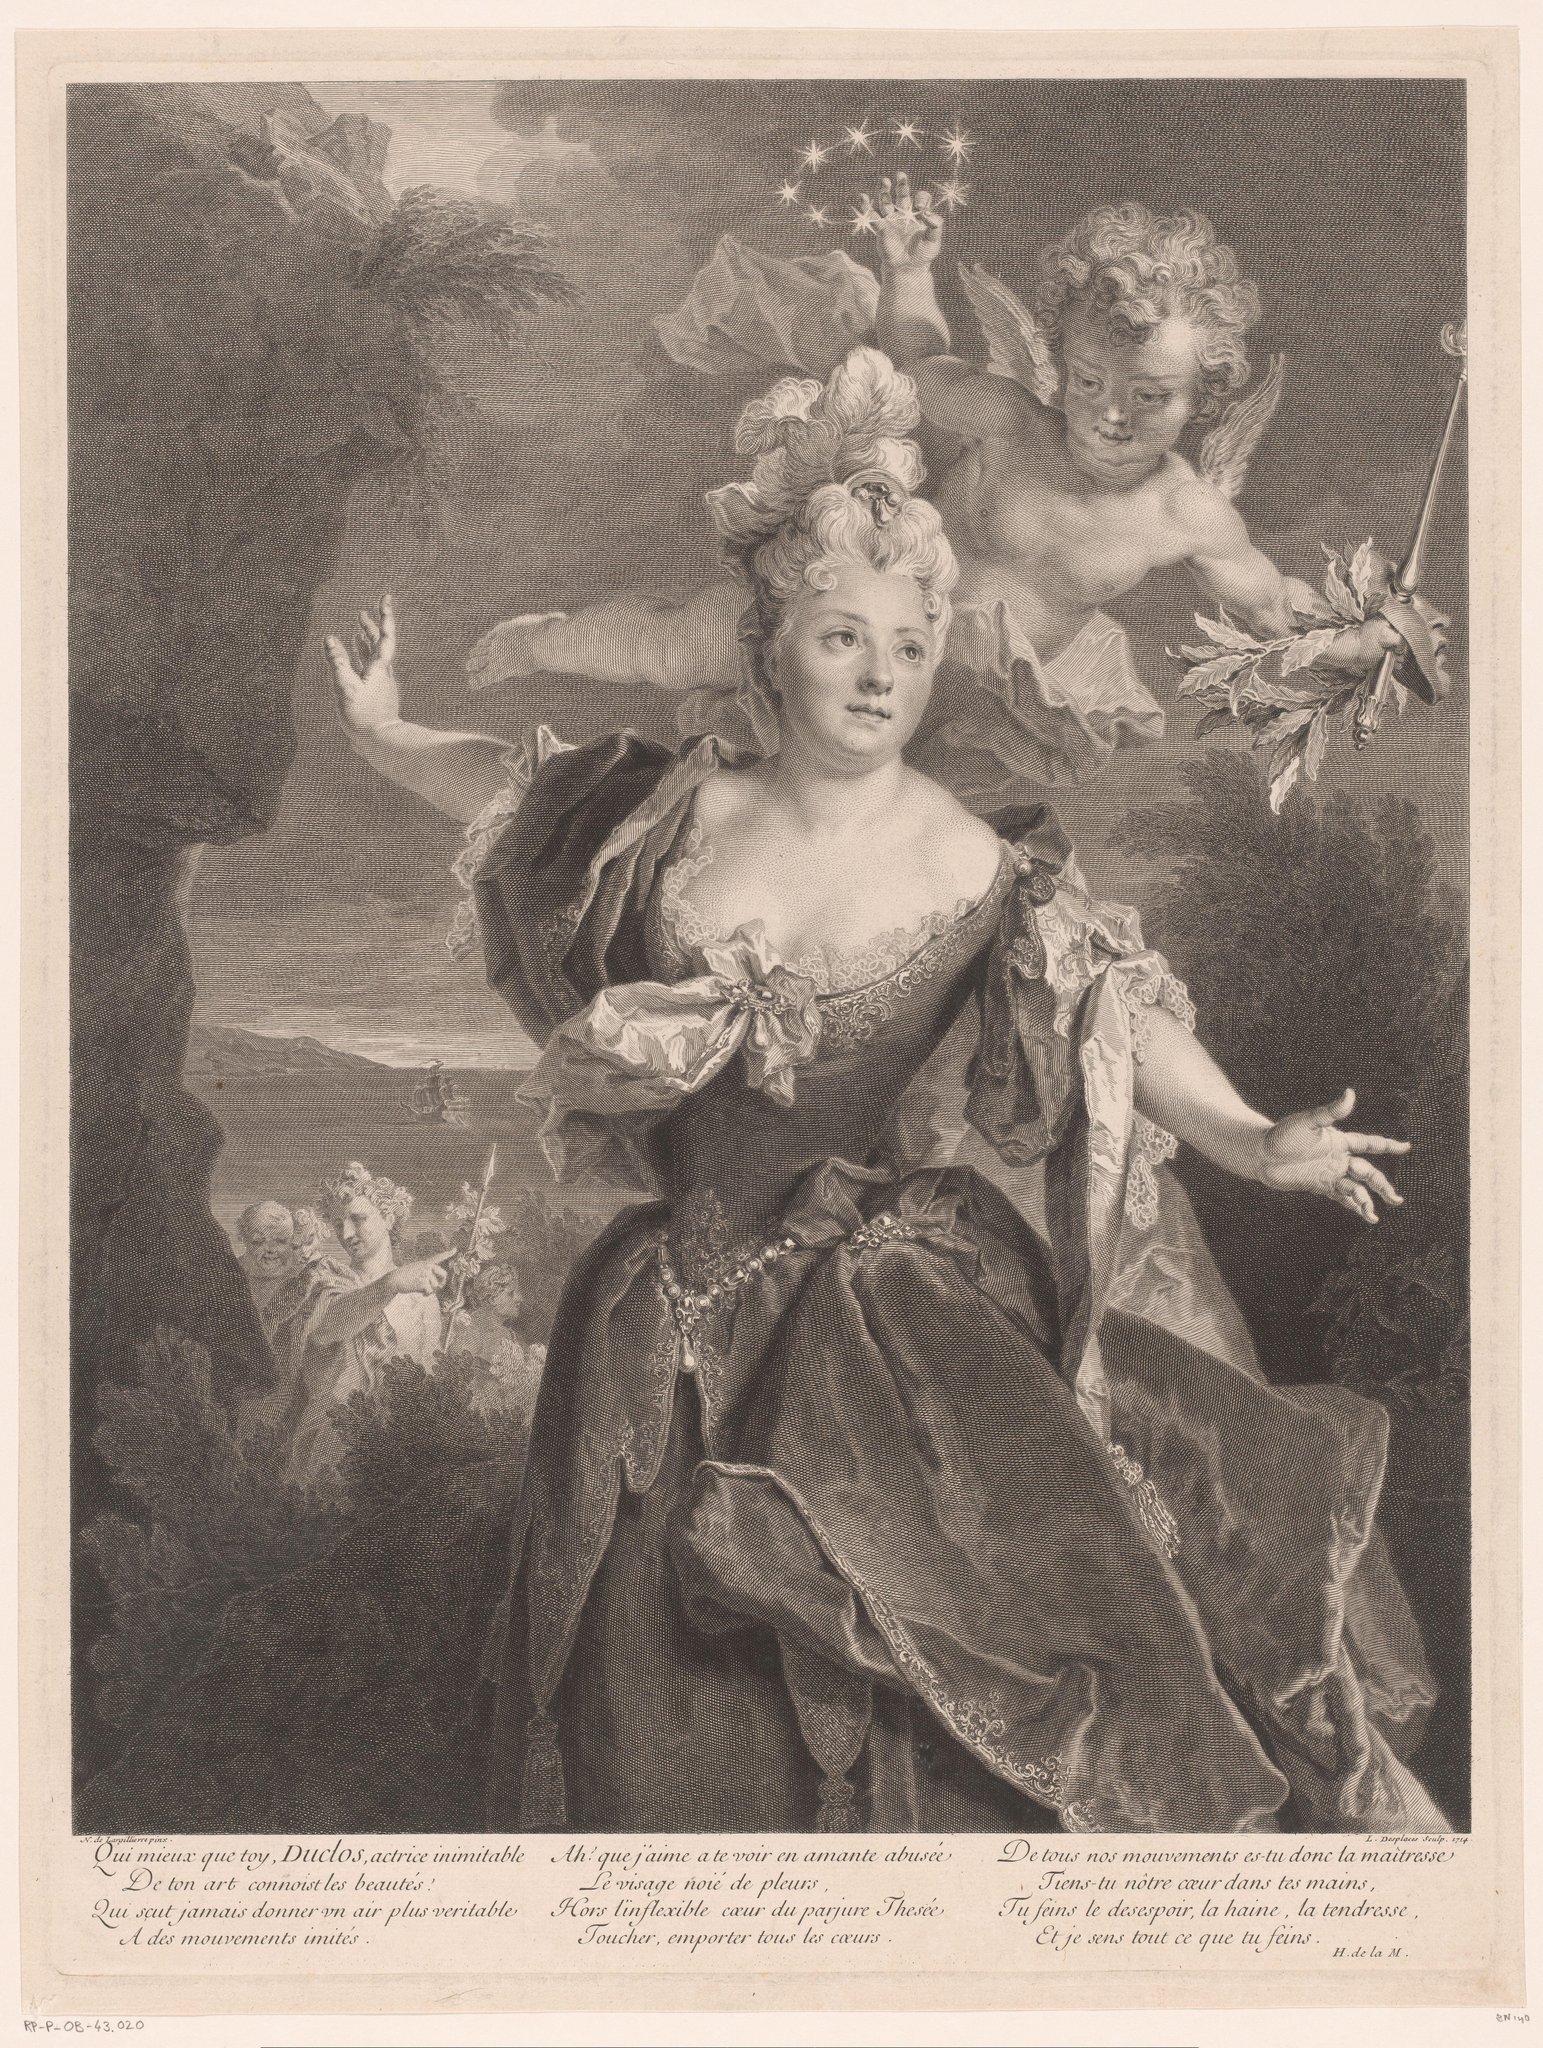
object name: print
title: Portret van Mademoiselle Duclos in de rol van Ariane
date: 1714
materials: paper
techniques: engraving, etching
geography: paris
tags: historical persons, portrait of actor, actress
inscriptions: collector's mark: Lugt 240